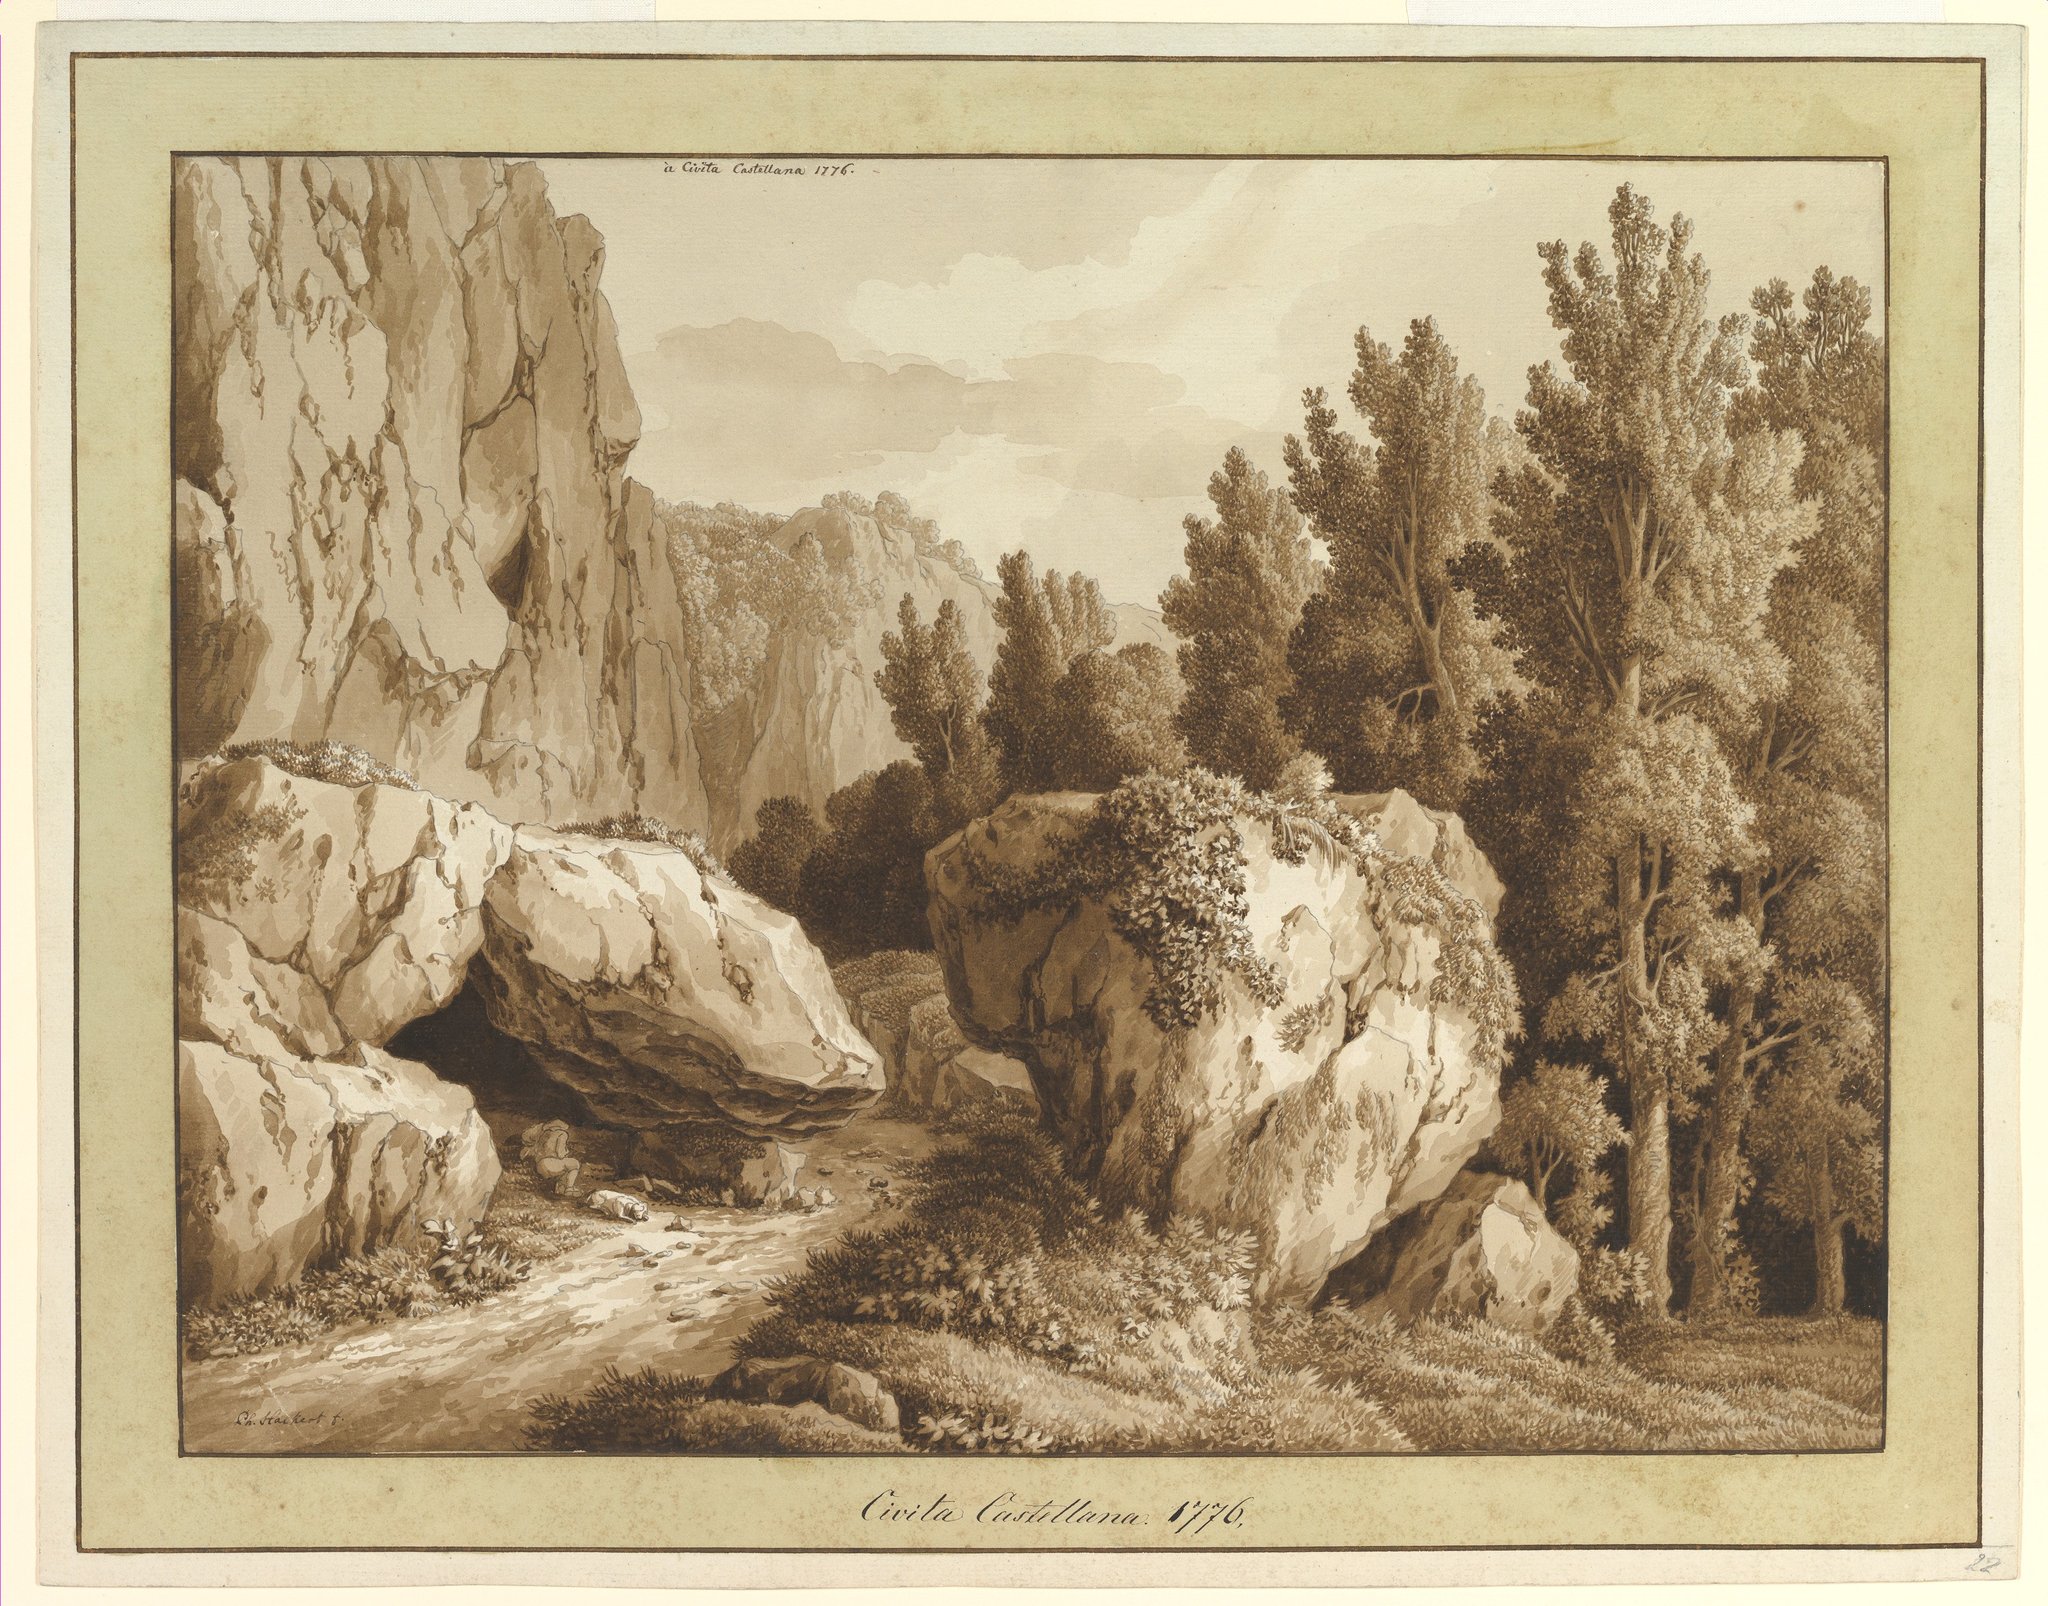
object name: drawing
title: A Rocky Landscape at Civita Castellana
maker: jacob philipp hackert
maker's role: artist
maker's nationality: german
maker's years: 1737-1807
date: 1776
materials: graphite, ink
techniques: brush, pen, wash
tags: landscapes,trees